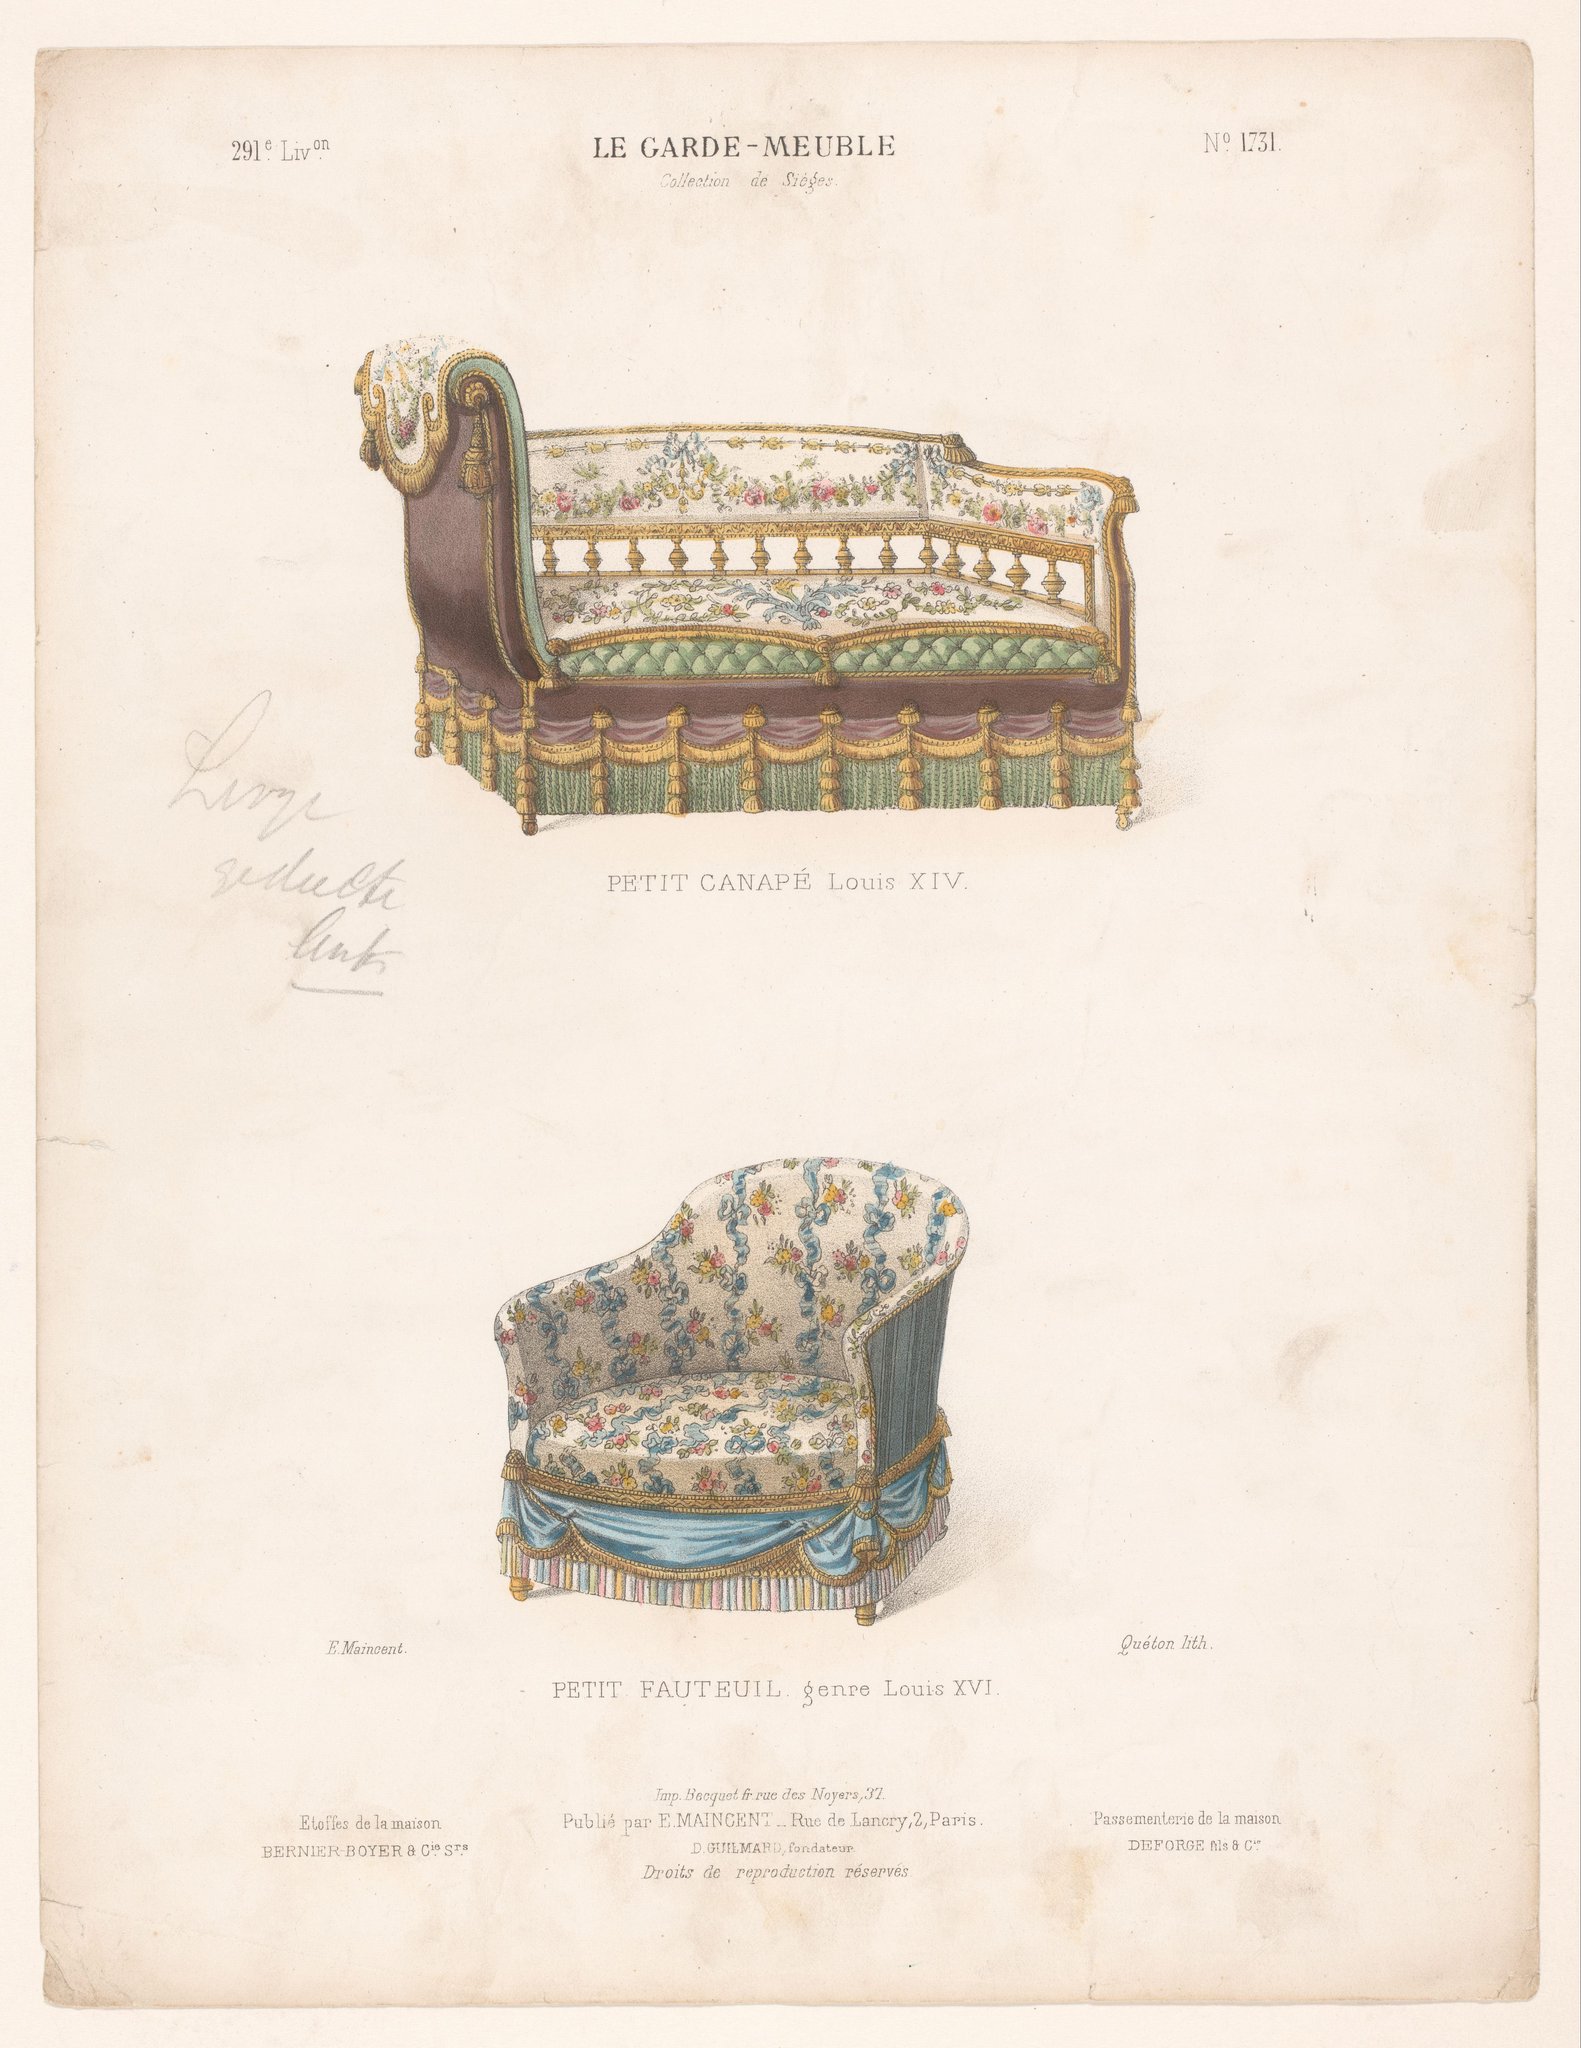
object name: print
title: Le garde-meuble / Collection de Sièges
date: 1885-1895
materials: paper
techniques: hand coloring, lithograph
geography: paris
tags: seating furniture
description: Ieder Livraison in de serie Le Garde-Meuble bevat negen platen: drie 'sièges' (zitmeubels), drie 'meubles' (diverse meubels zoals tafels en kasten) en drie 'tentures' (gordijnen en draperieën).